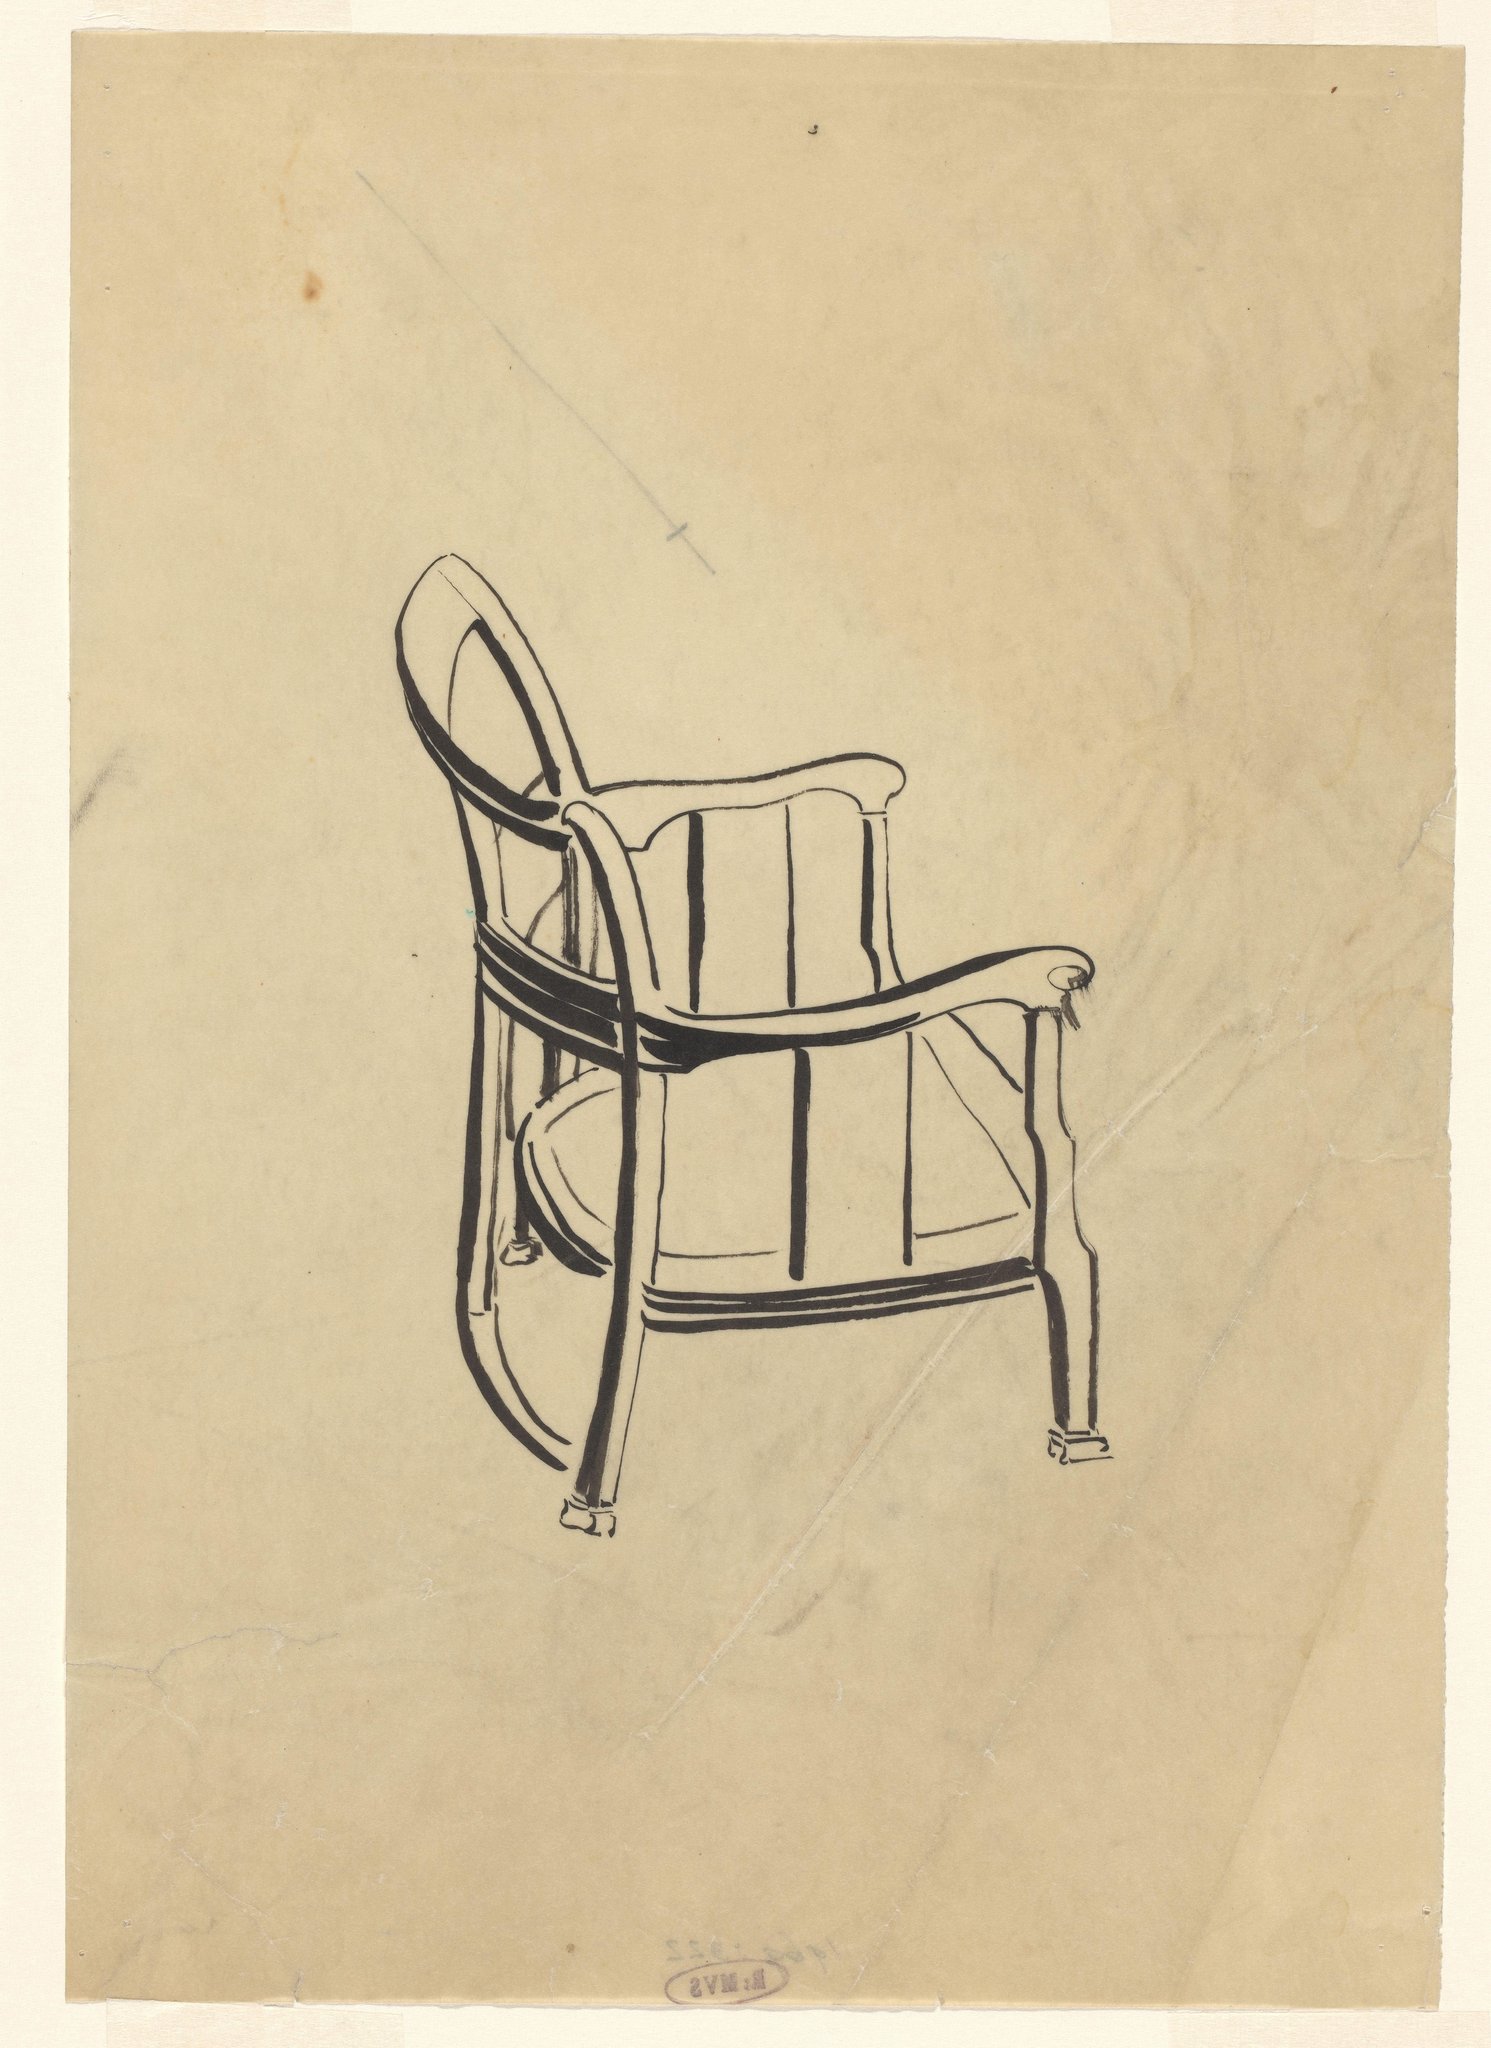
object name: design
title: Ontwerp voor een stoel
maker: carel adolph lion cachet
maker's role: draughtsman, print maker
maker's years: 1864-1945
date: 1874-1945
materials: paper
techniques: brush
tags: chair